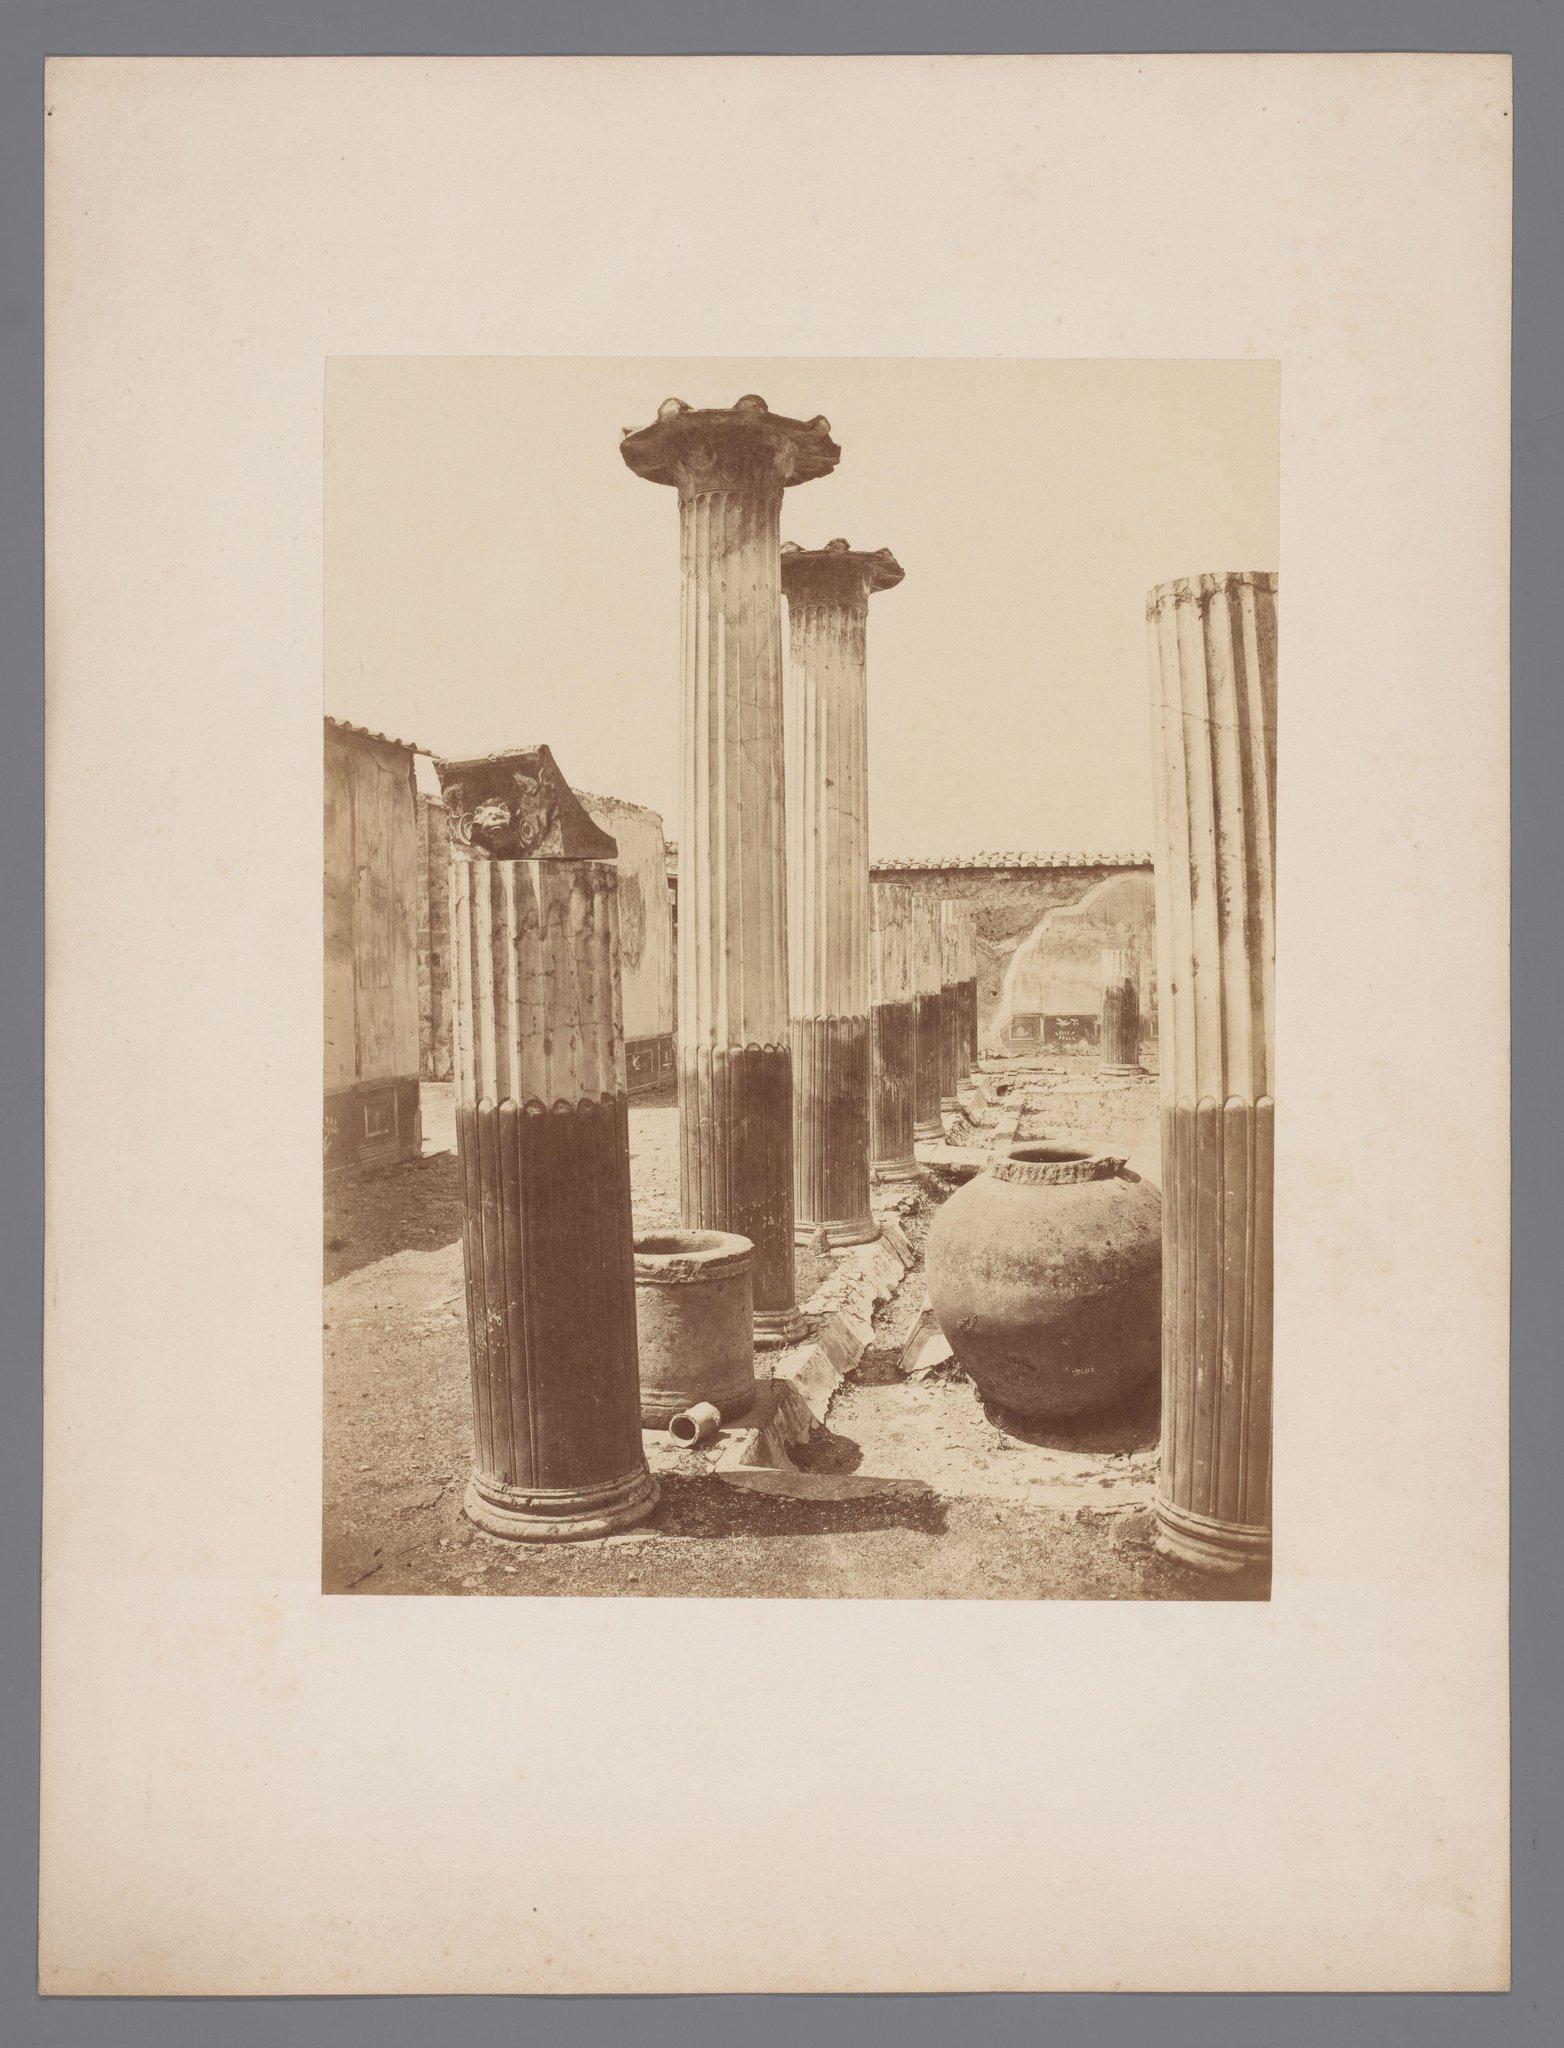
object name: photograph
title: Ruïne te Pompeï, Italië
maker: giorgio sommer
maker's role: fotograaf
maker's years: 1834-1914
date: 1857-1875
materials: cardboard, paper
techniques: albumen print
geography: pompeii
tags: urban housing, column, pillar ~ architecture, ruin of a building ~ architecture, pompeii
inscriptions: collector's mark: ‘VOSMAER’